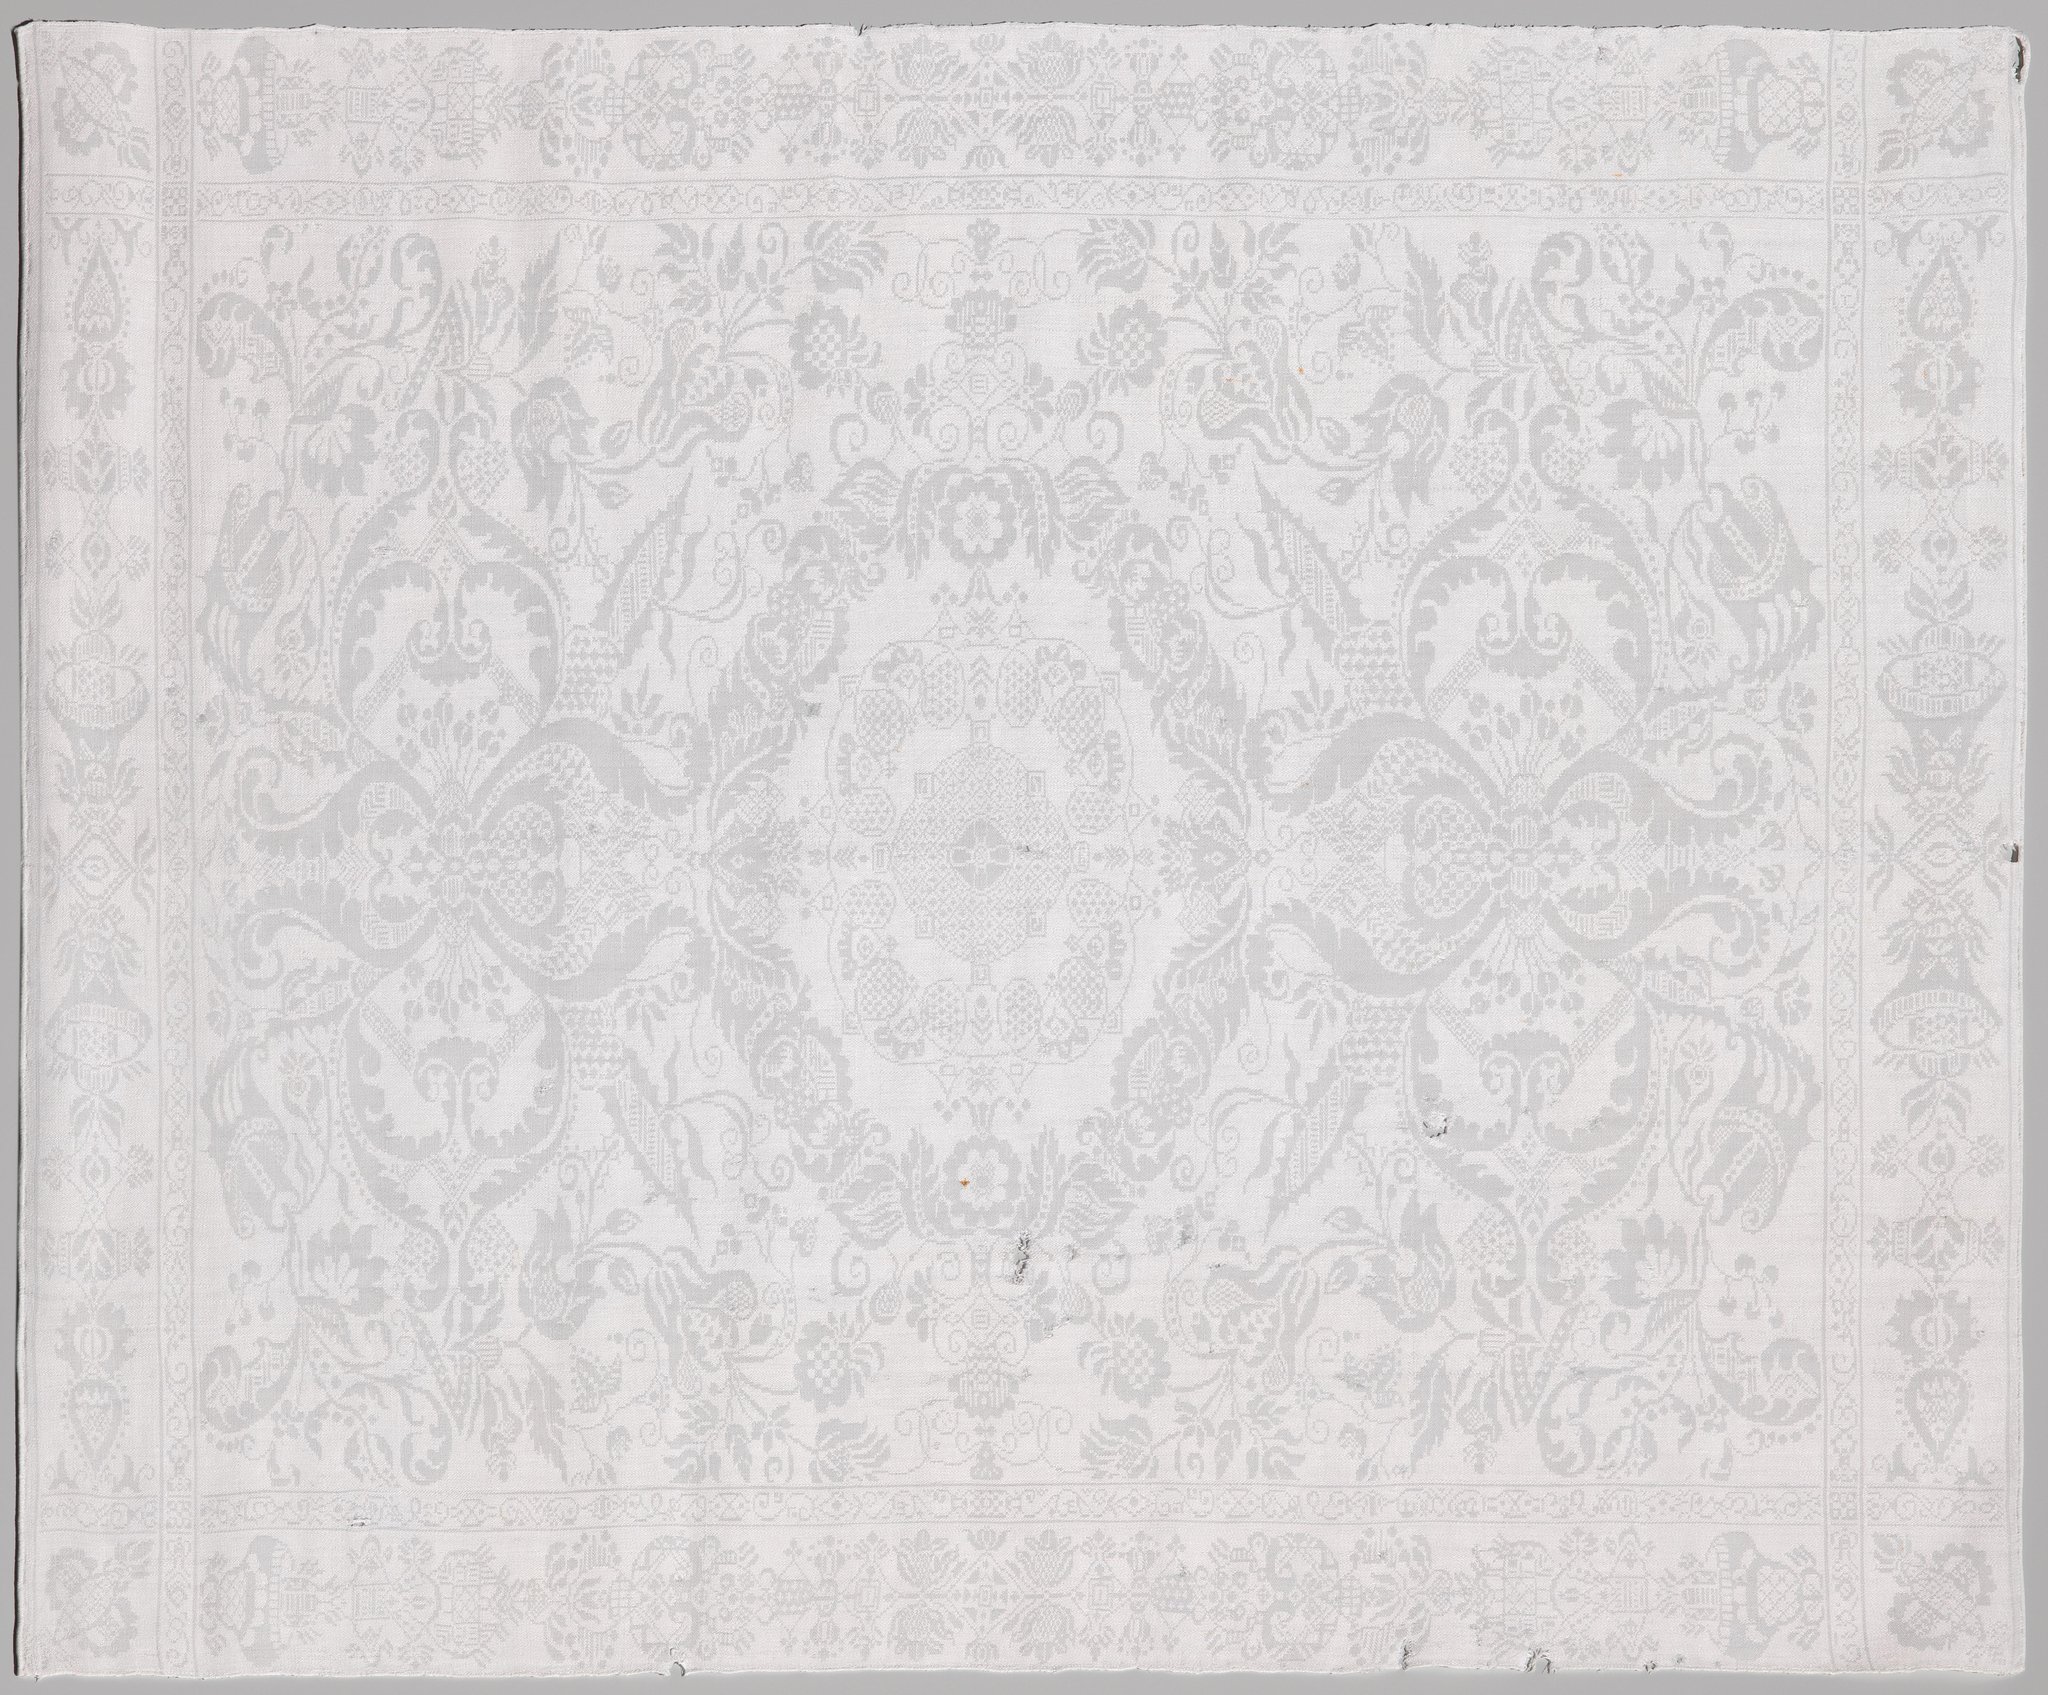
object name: napkin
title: Servet met bizar patroon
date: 1705-1710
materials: linen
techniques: damask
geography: flanders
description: Wit linnen damasten servet met centraal volledig gevuld vlak met een combinatie van bloemen, slingerranken, bladeren, kantpatroon en bizare elementen.